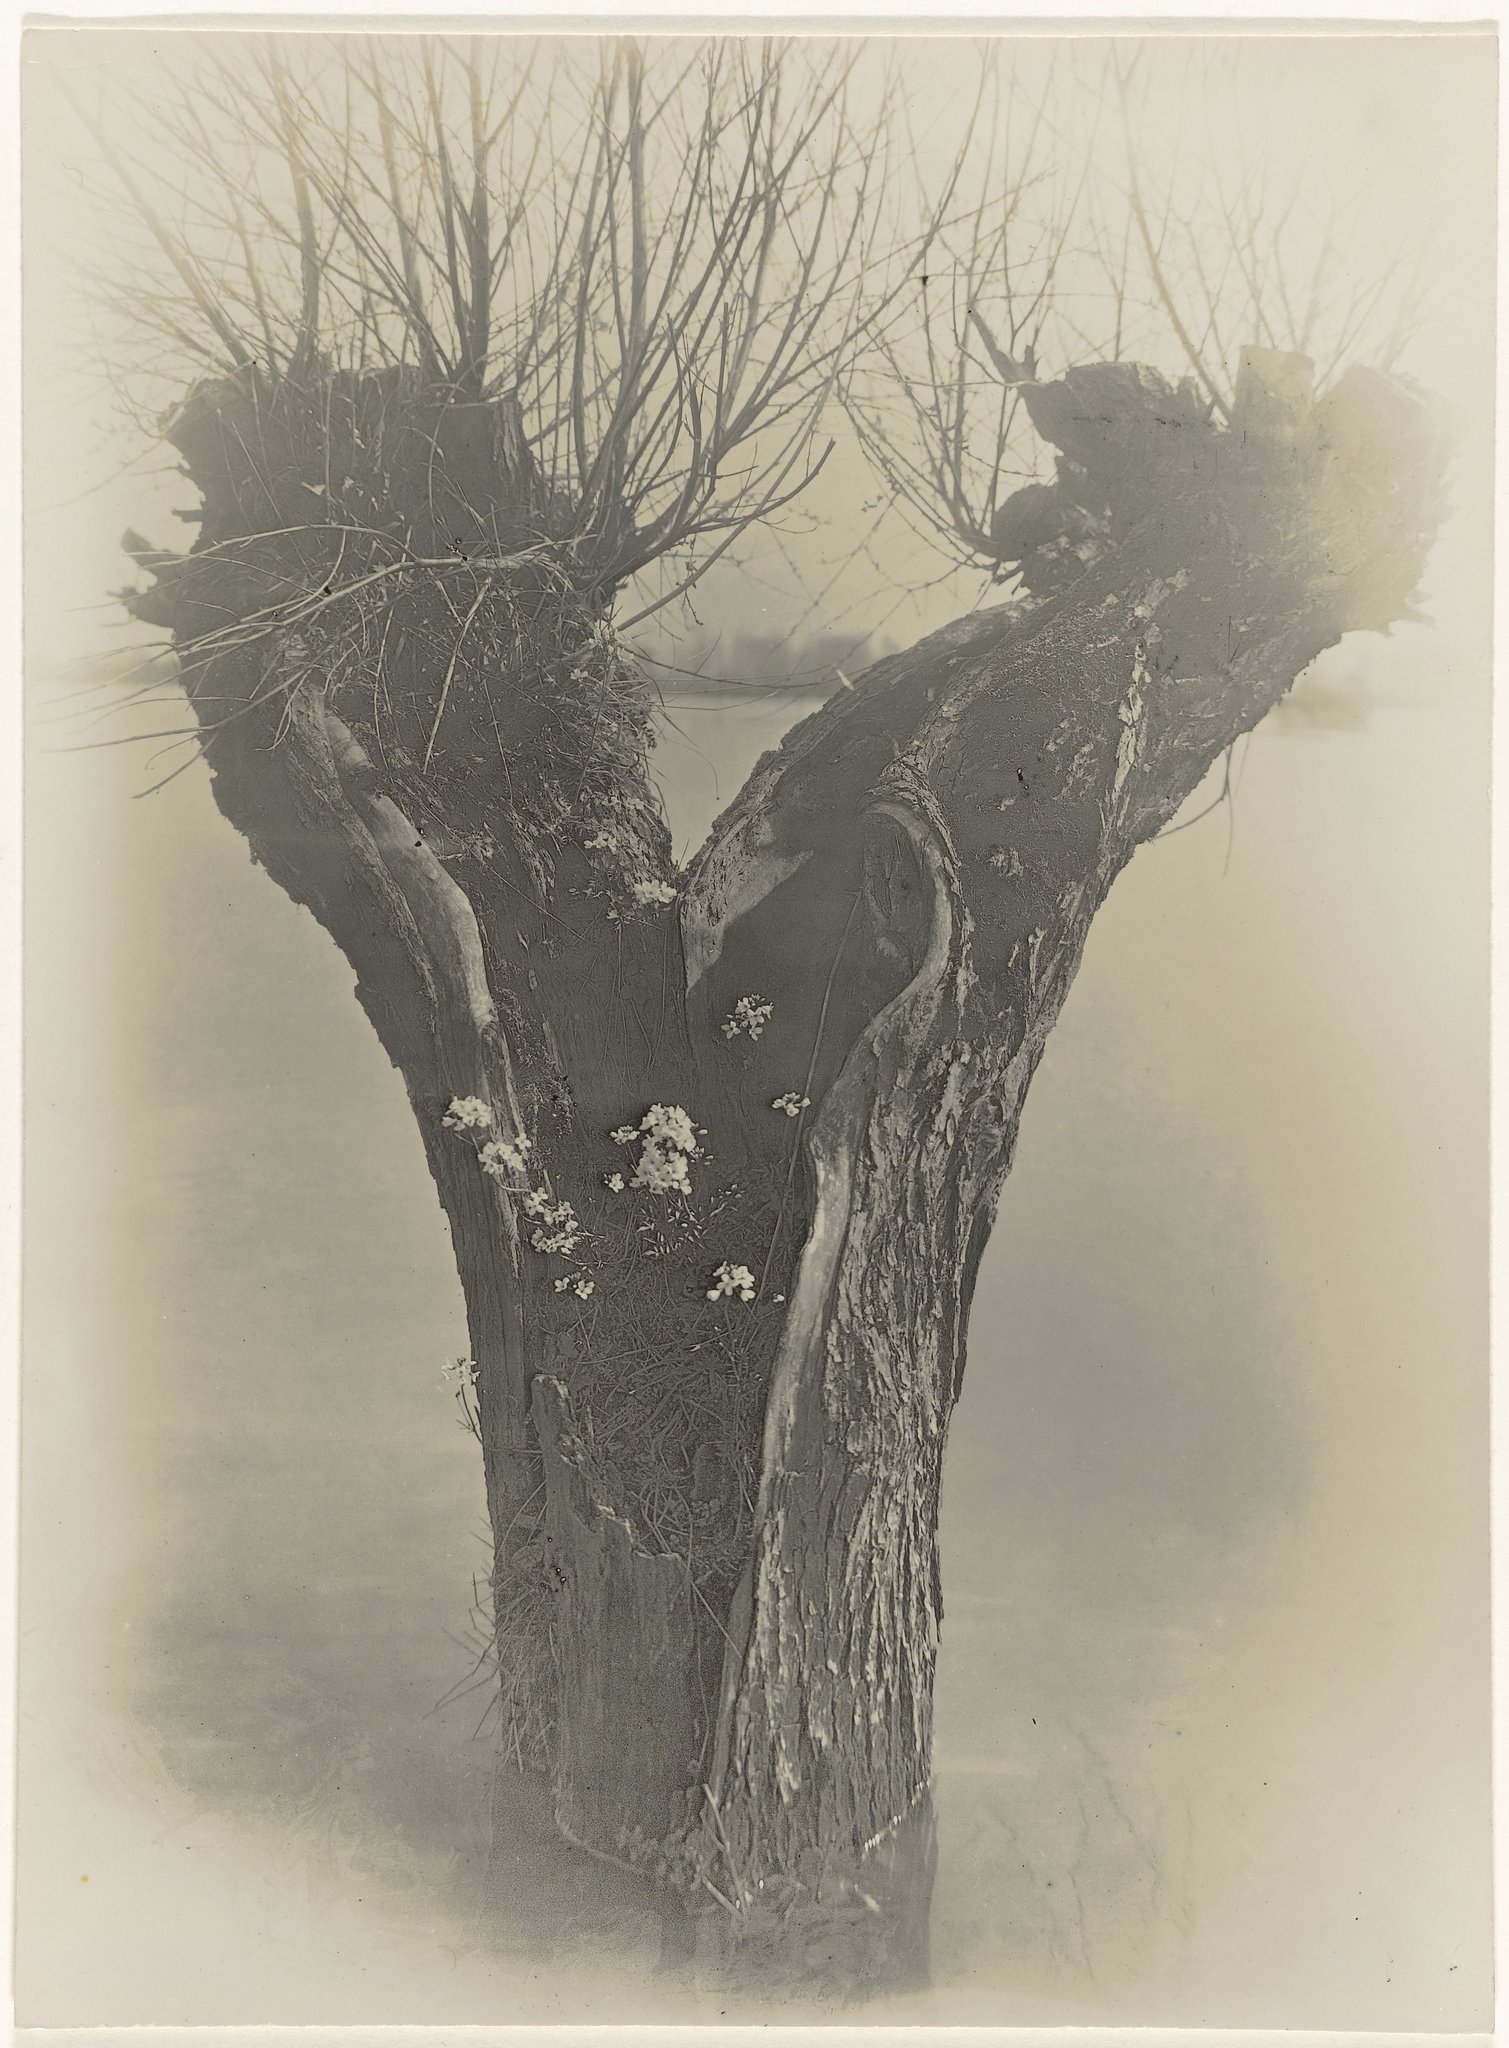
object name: photograph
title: Knotwilg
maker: richard tepe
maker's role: fotograaf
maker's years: 1864-1952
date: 1900-1940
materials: photographic support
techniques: gelatin silver print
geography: netherlands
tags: trees: willow